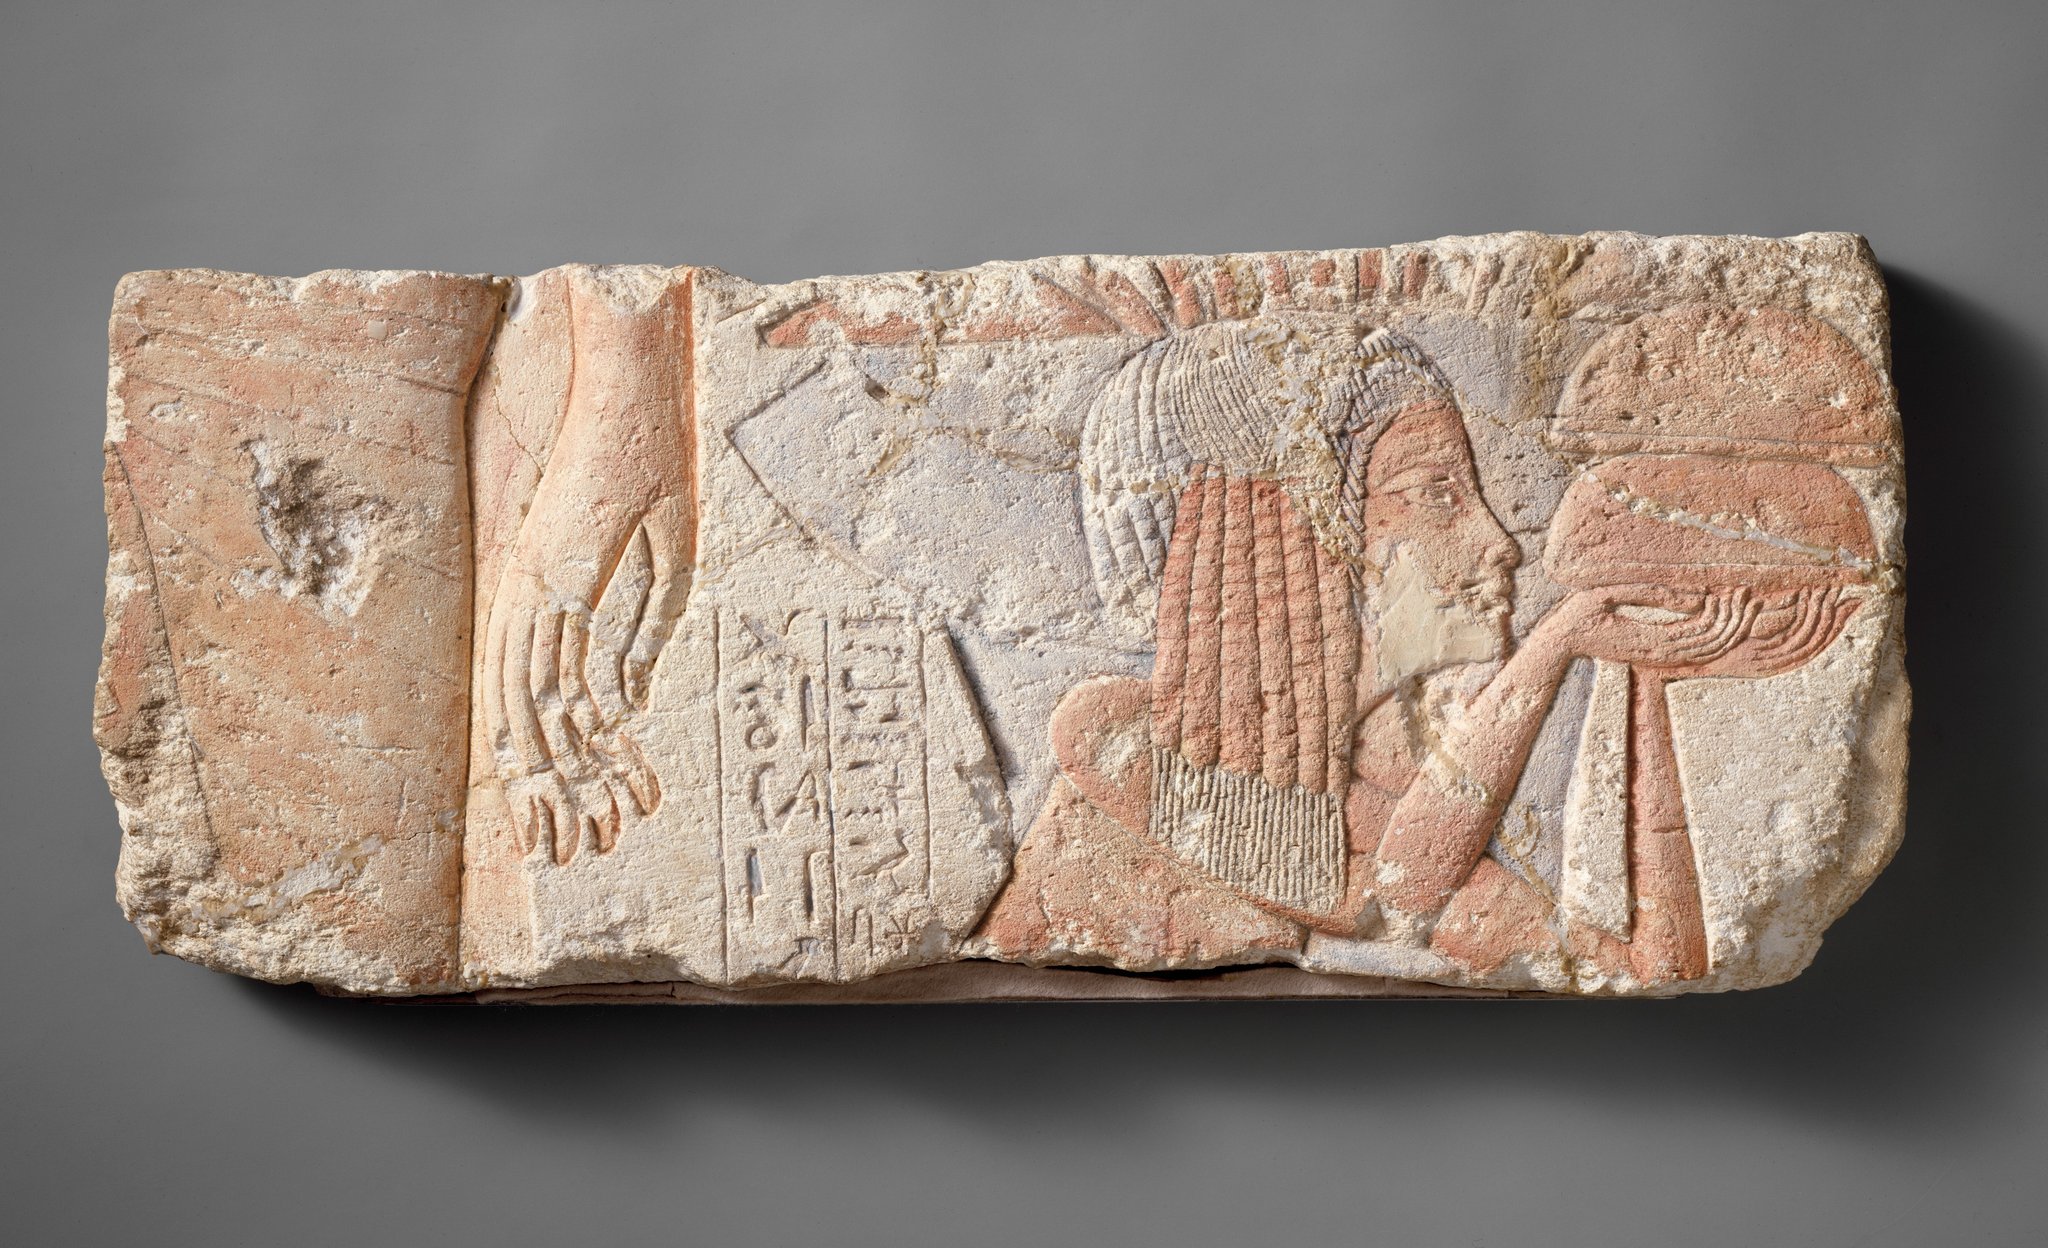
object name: talatat, nurse tia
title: Relief Depicting the Nurse Tia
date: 1353-1336 BCE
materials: limestone, paint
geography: middle egypt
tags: bread,hands,women